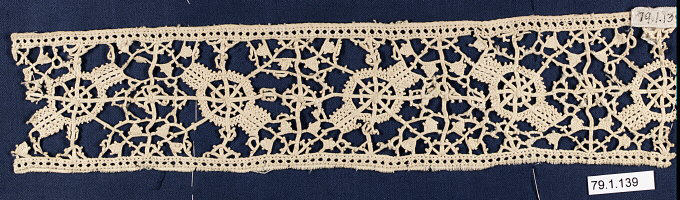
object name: strip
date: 1501-1600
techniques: lace